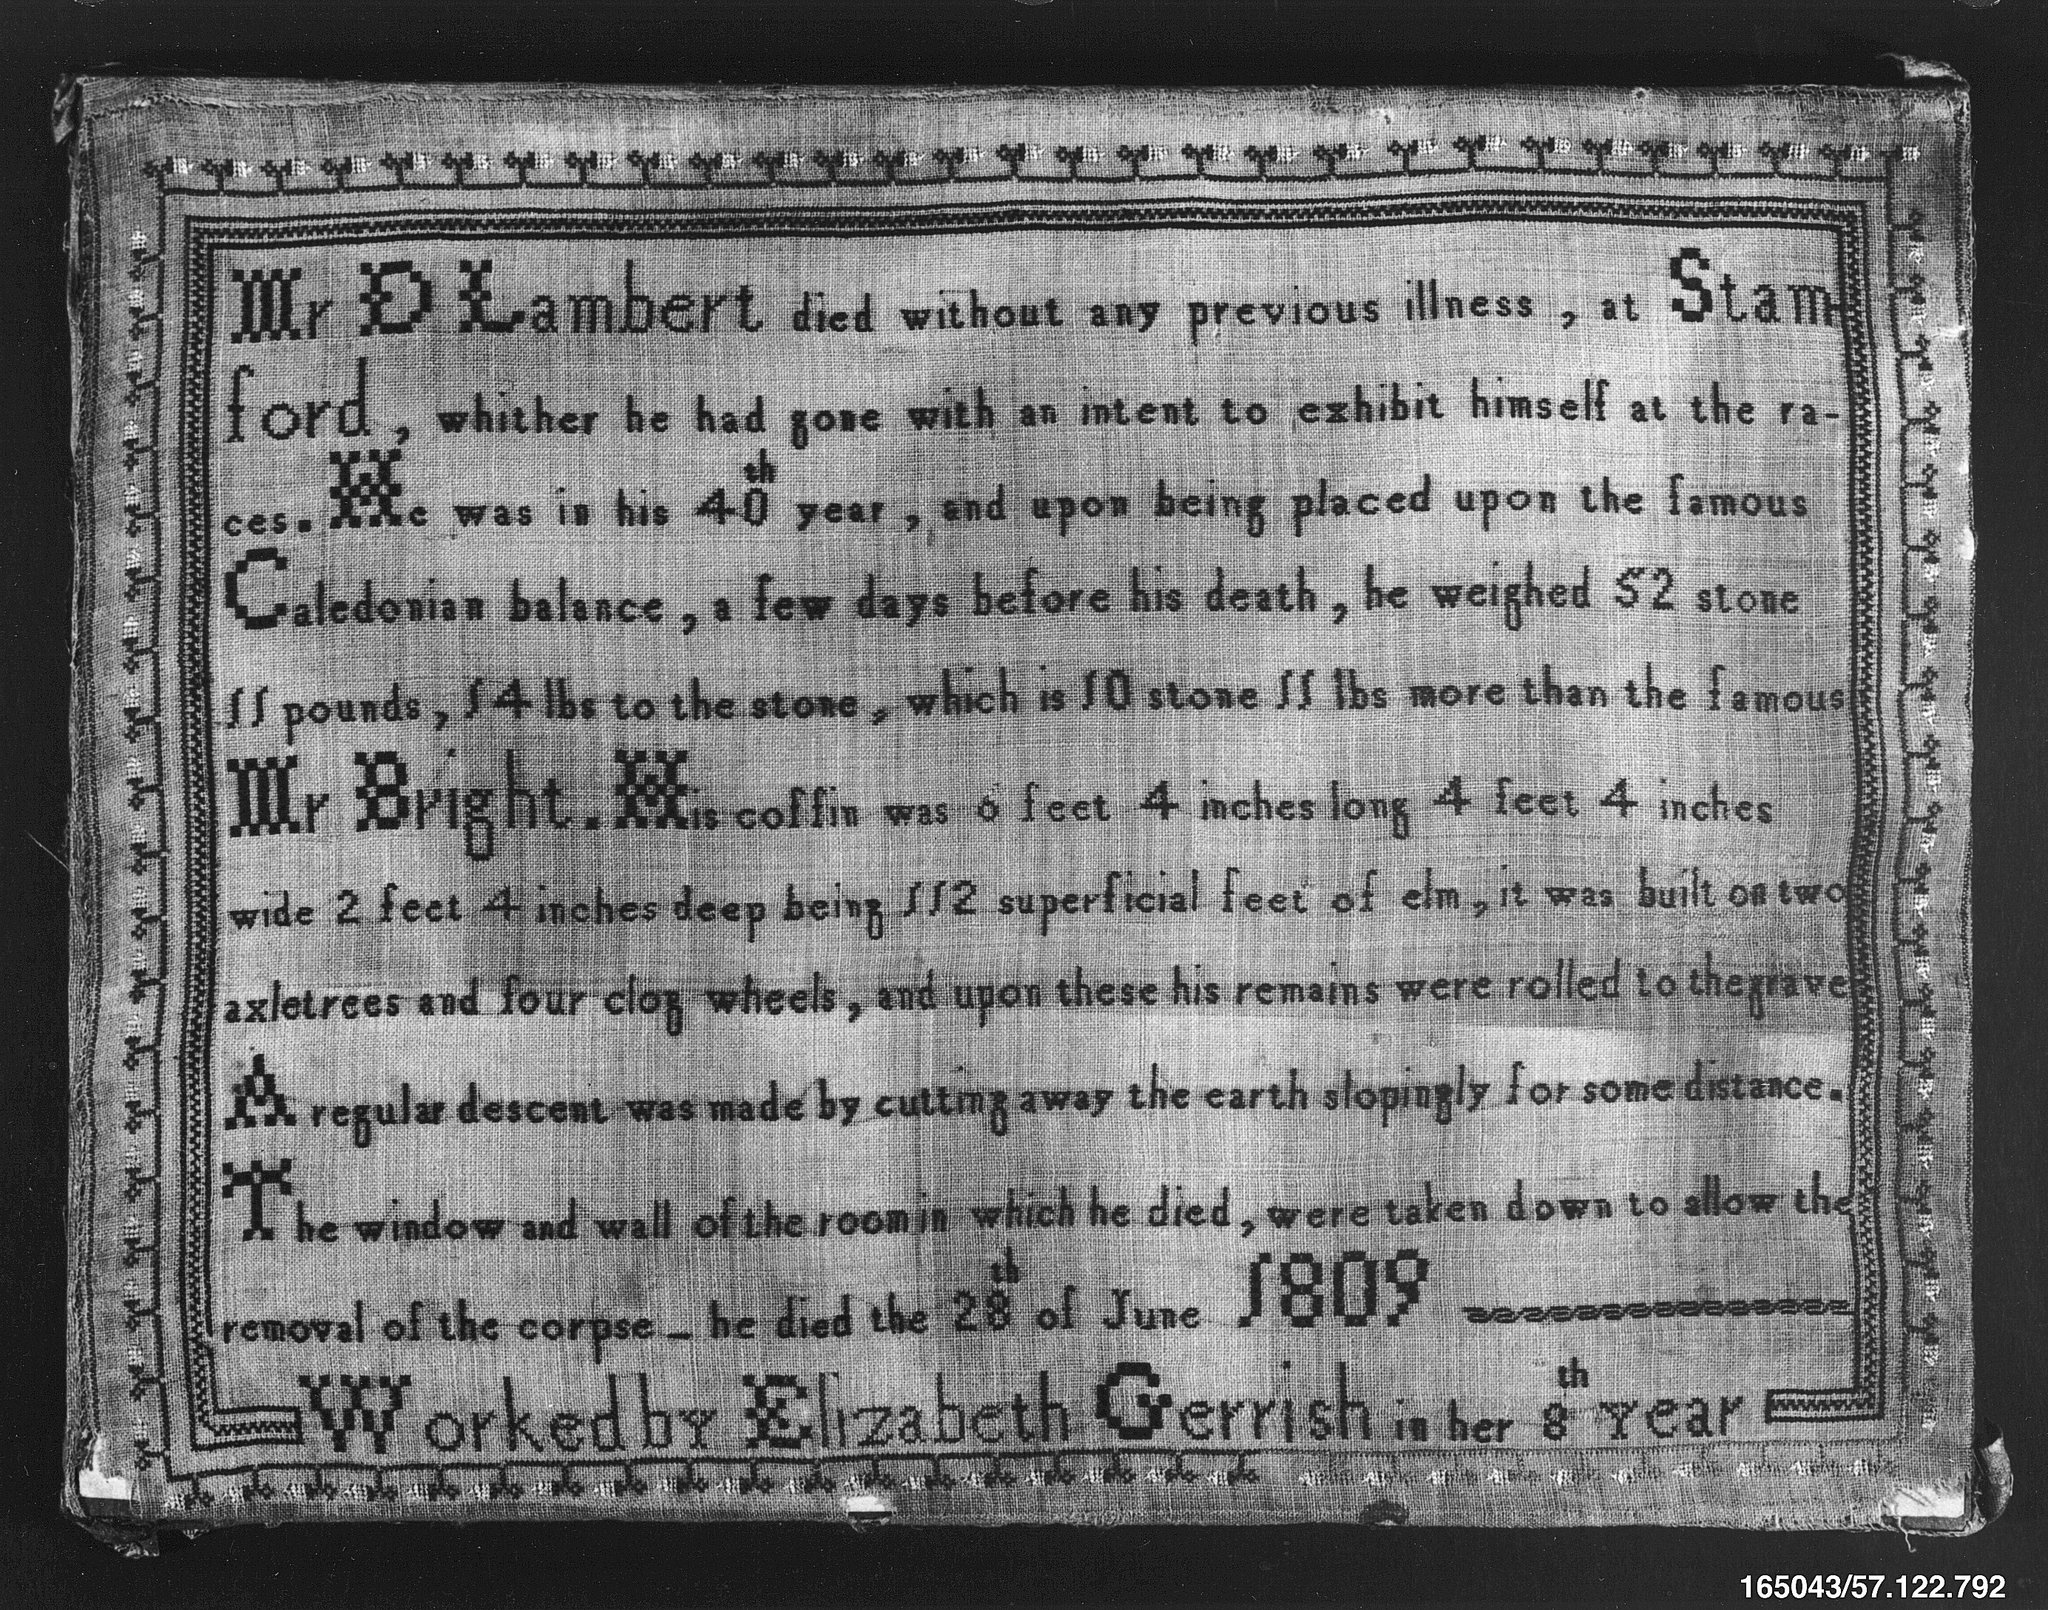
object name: sampler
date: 1809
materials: silk, wool